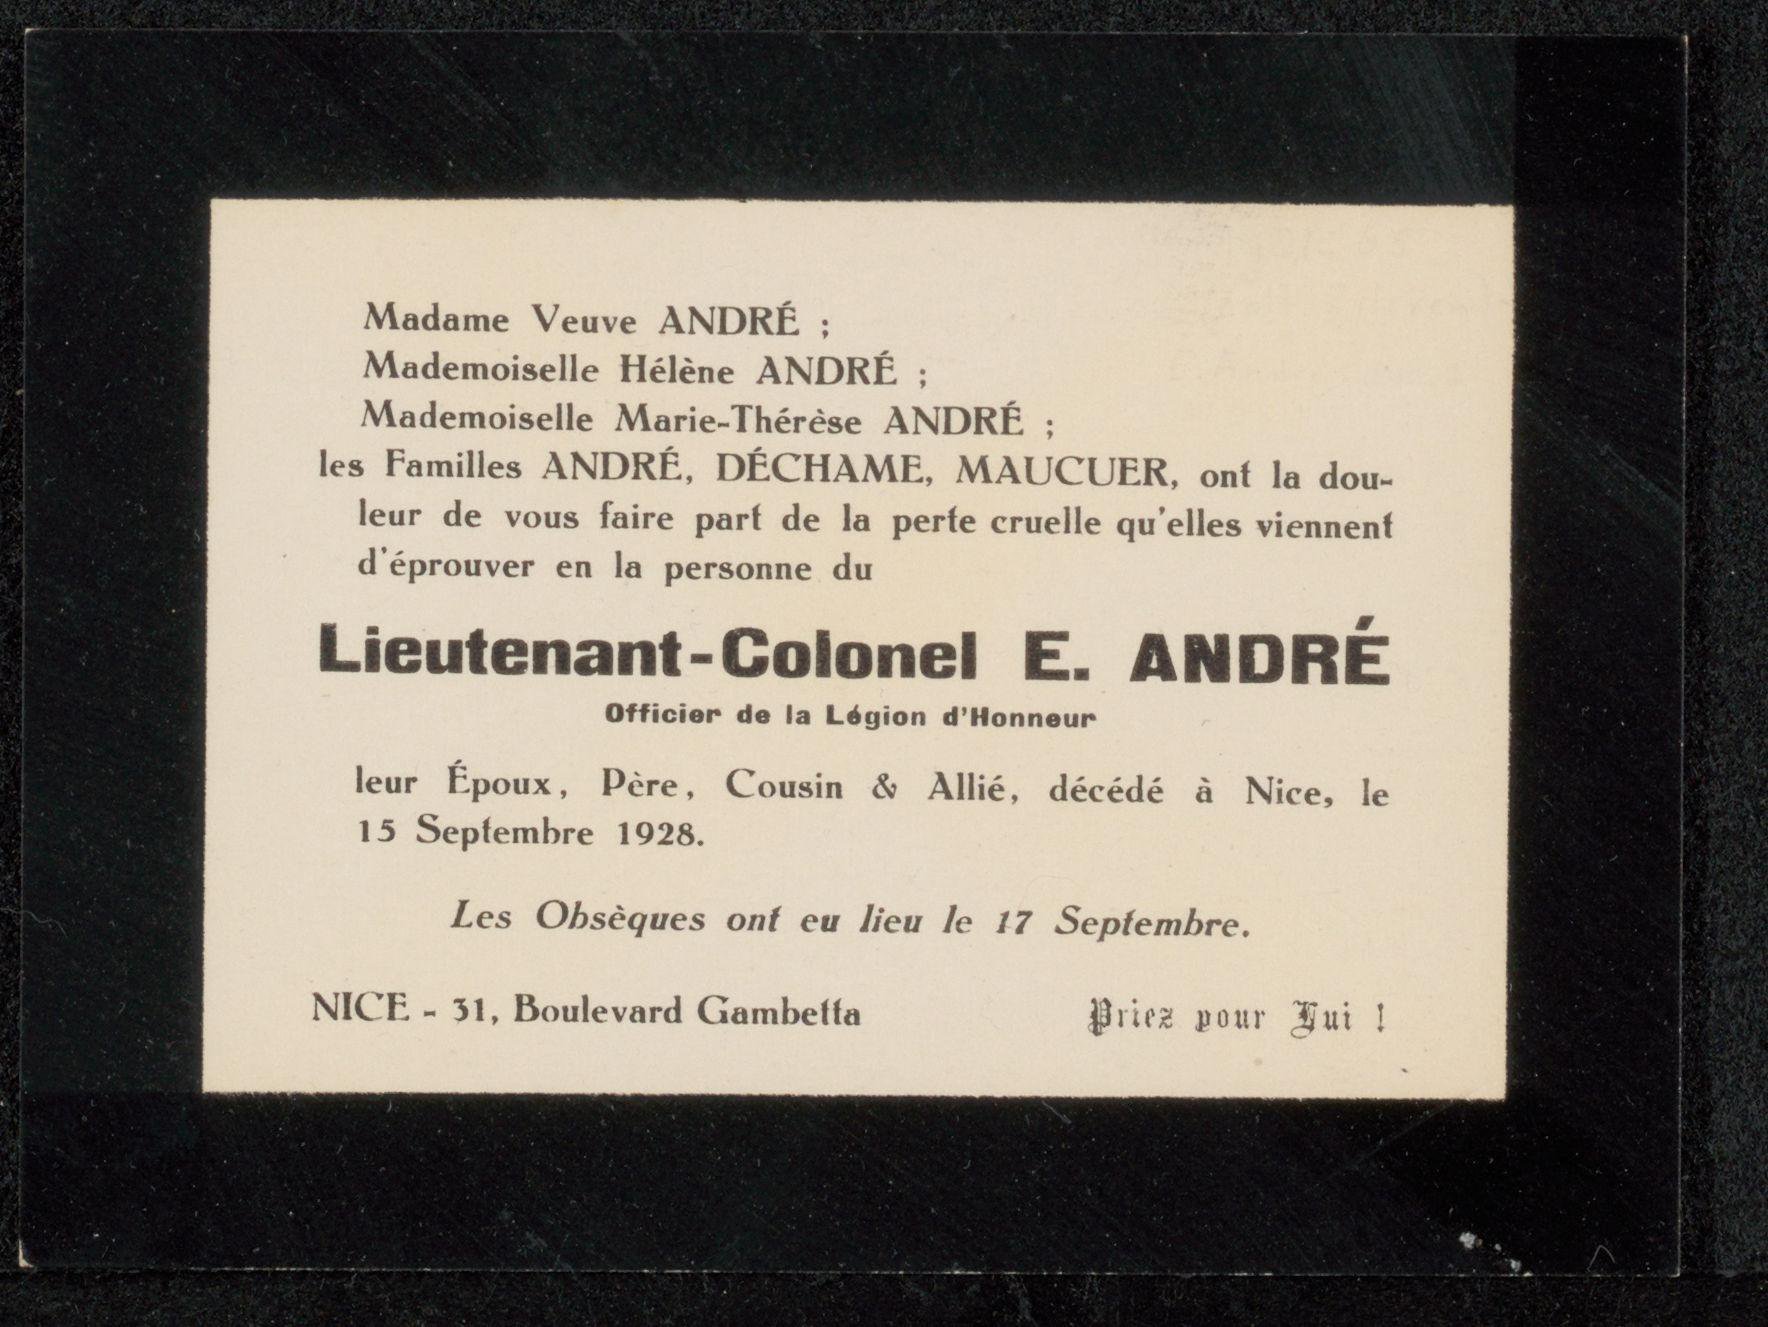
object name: overlijdensbericht, overlijdensadvertentie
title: Overlijdensbericht aan Philip Zilcken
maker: Anonymous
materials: cardboard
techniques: printing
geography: france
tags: e. andré, the hague, painter, draughtsman, philip zilcken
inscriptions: collector's mark: ‘RPK’